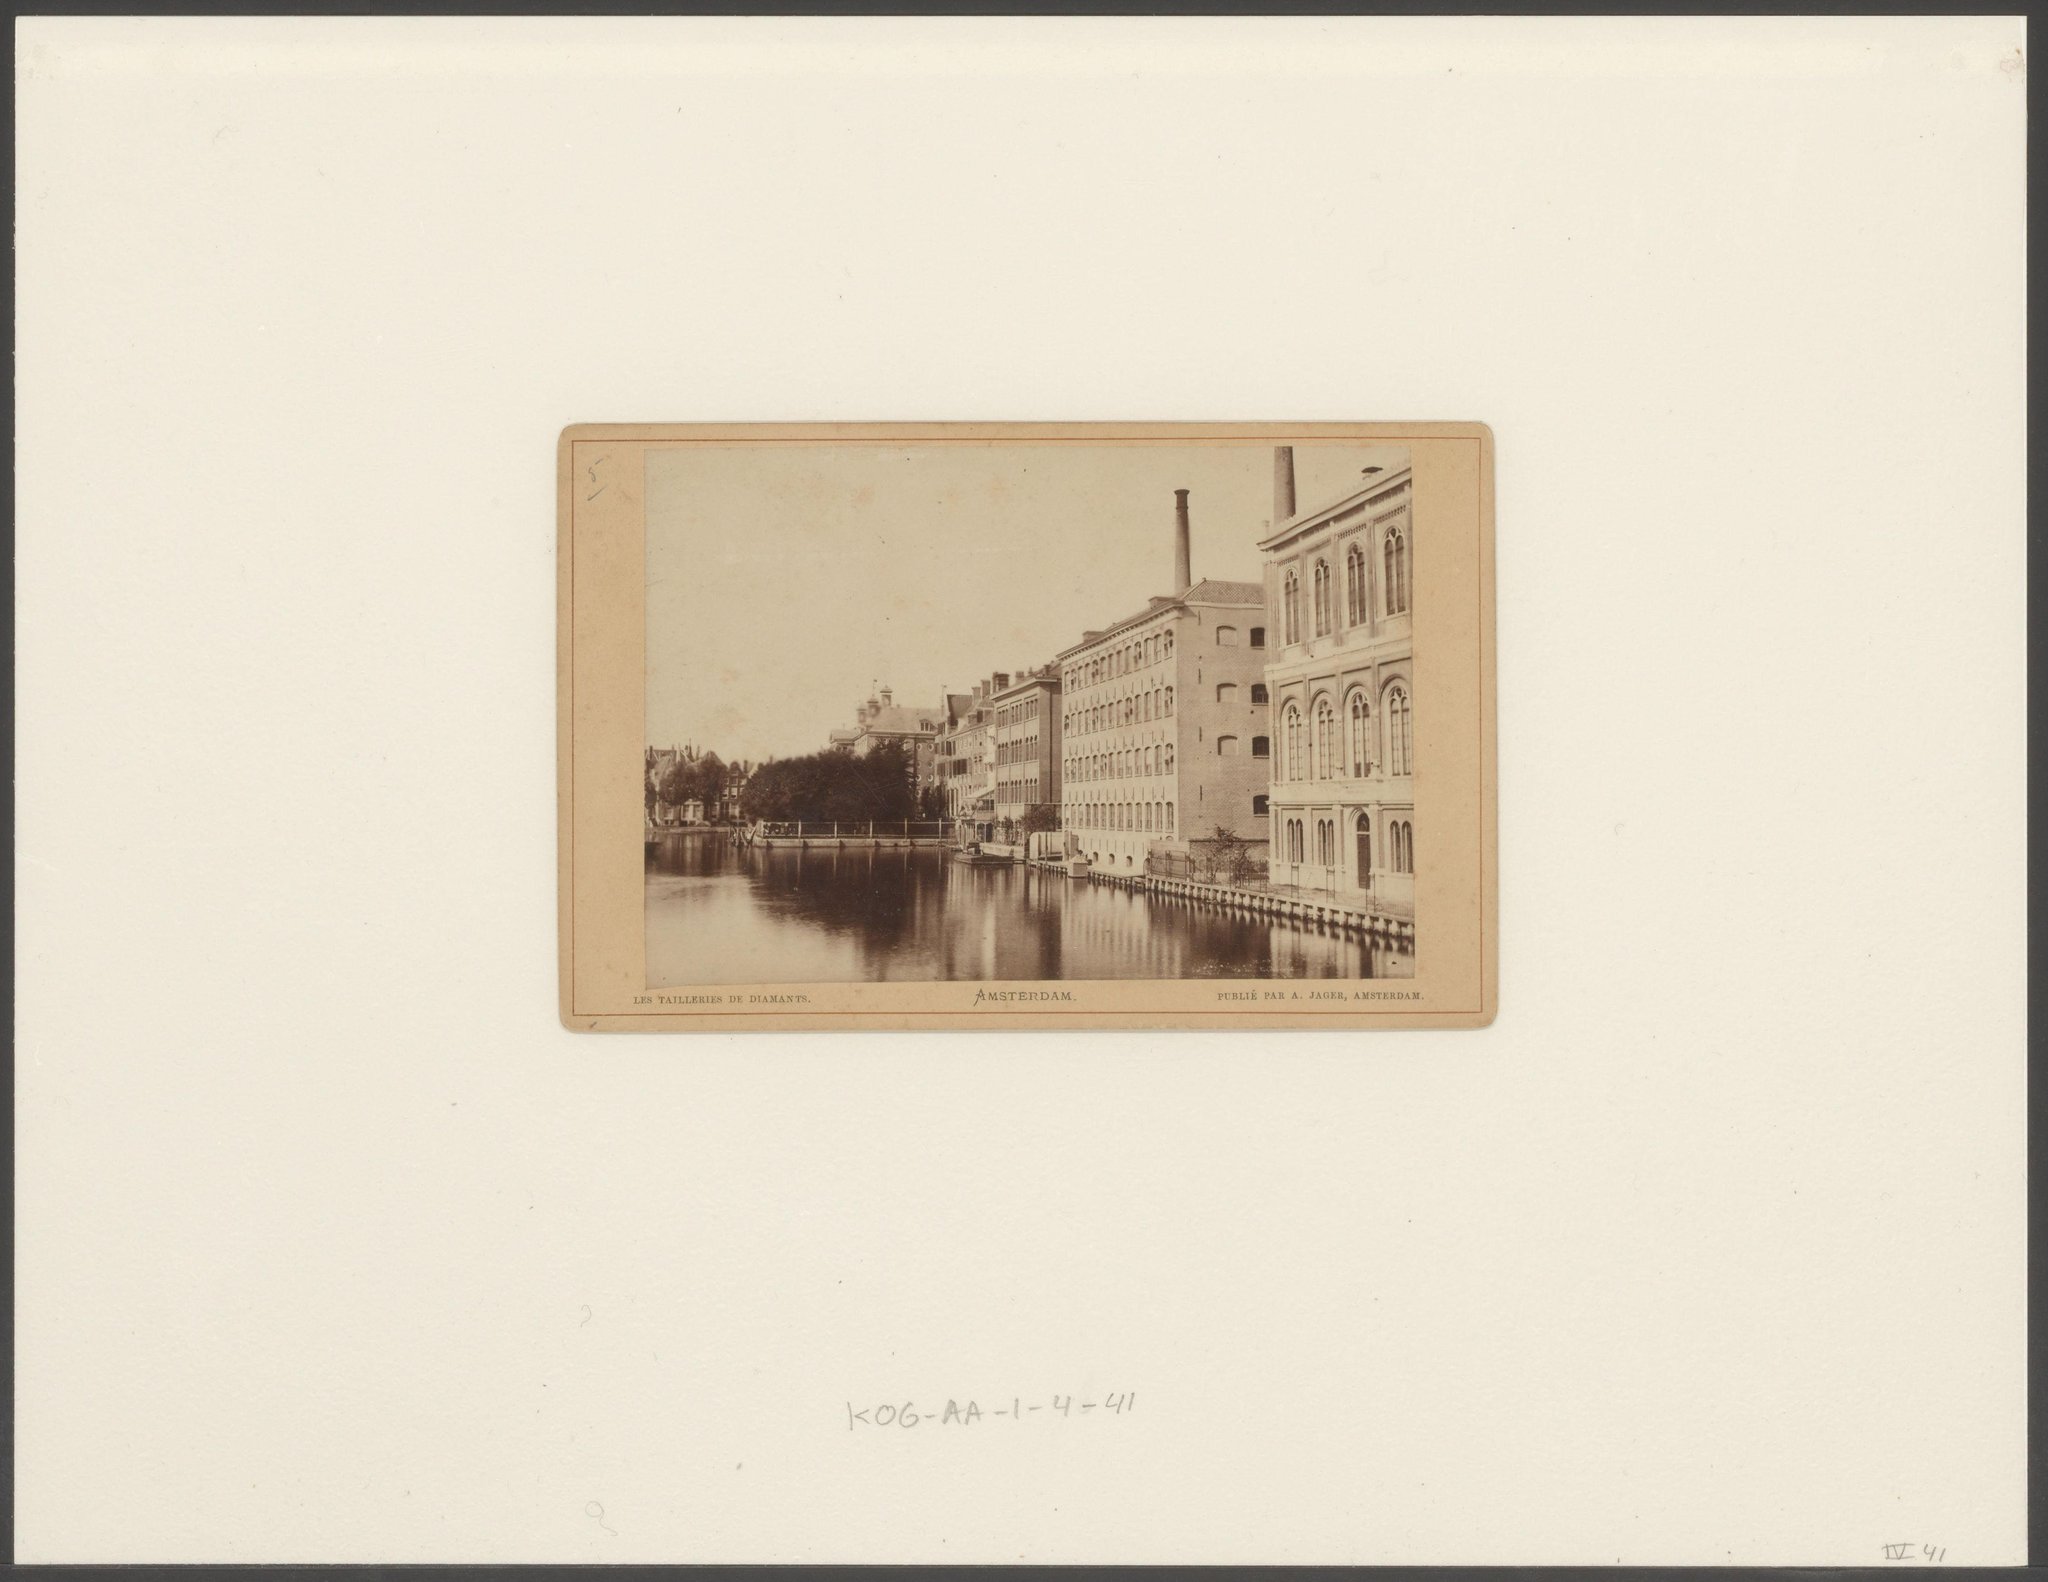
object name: cabinet photograph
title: Gezicht op de Binnen-Amstel en het Diaconieweeshuis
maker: andries jager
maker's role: publisher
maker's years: 1825-1905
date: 1849-1905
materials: cardboard, paper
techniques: albumen print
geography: amsterdam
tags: city-view in general; 'veduta', canal, orphanage, bridge in city across river, canal, etc.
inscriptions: inscription: ‘Oude Diaconie weeshuis / 33’, collector's mark: ‘4’ Lugt 1641b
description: Onderwerpsrubriek binnen de Atlas Amsterdam: Amstel van Doelensluis tot Blauwbrug.